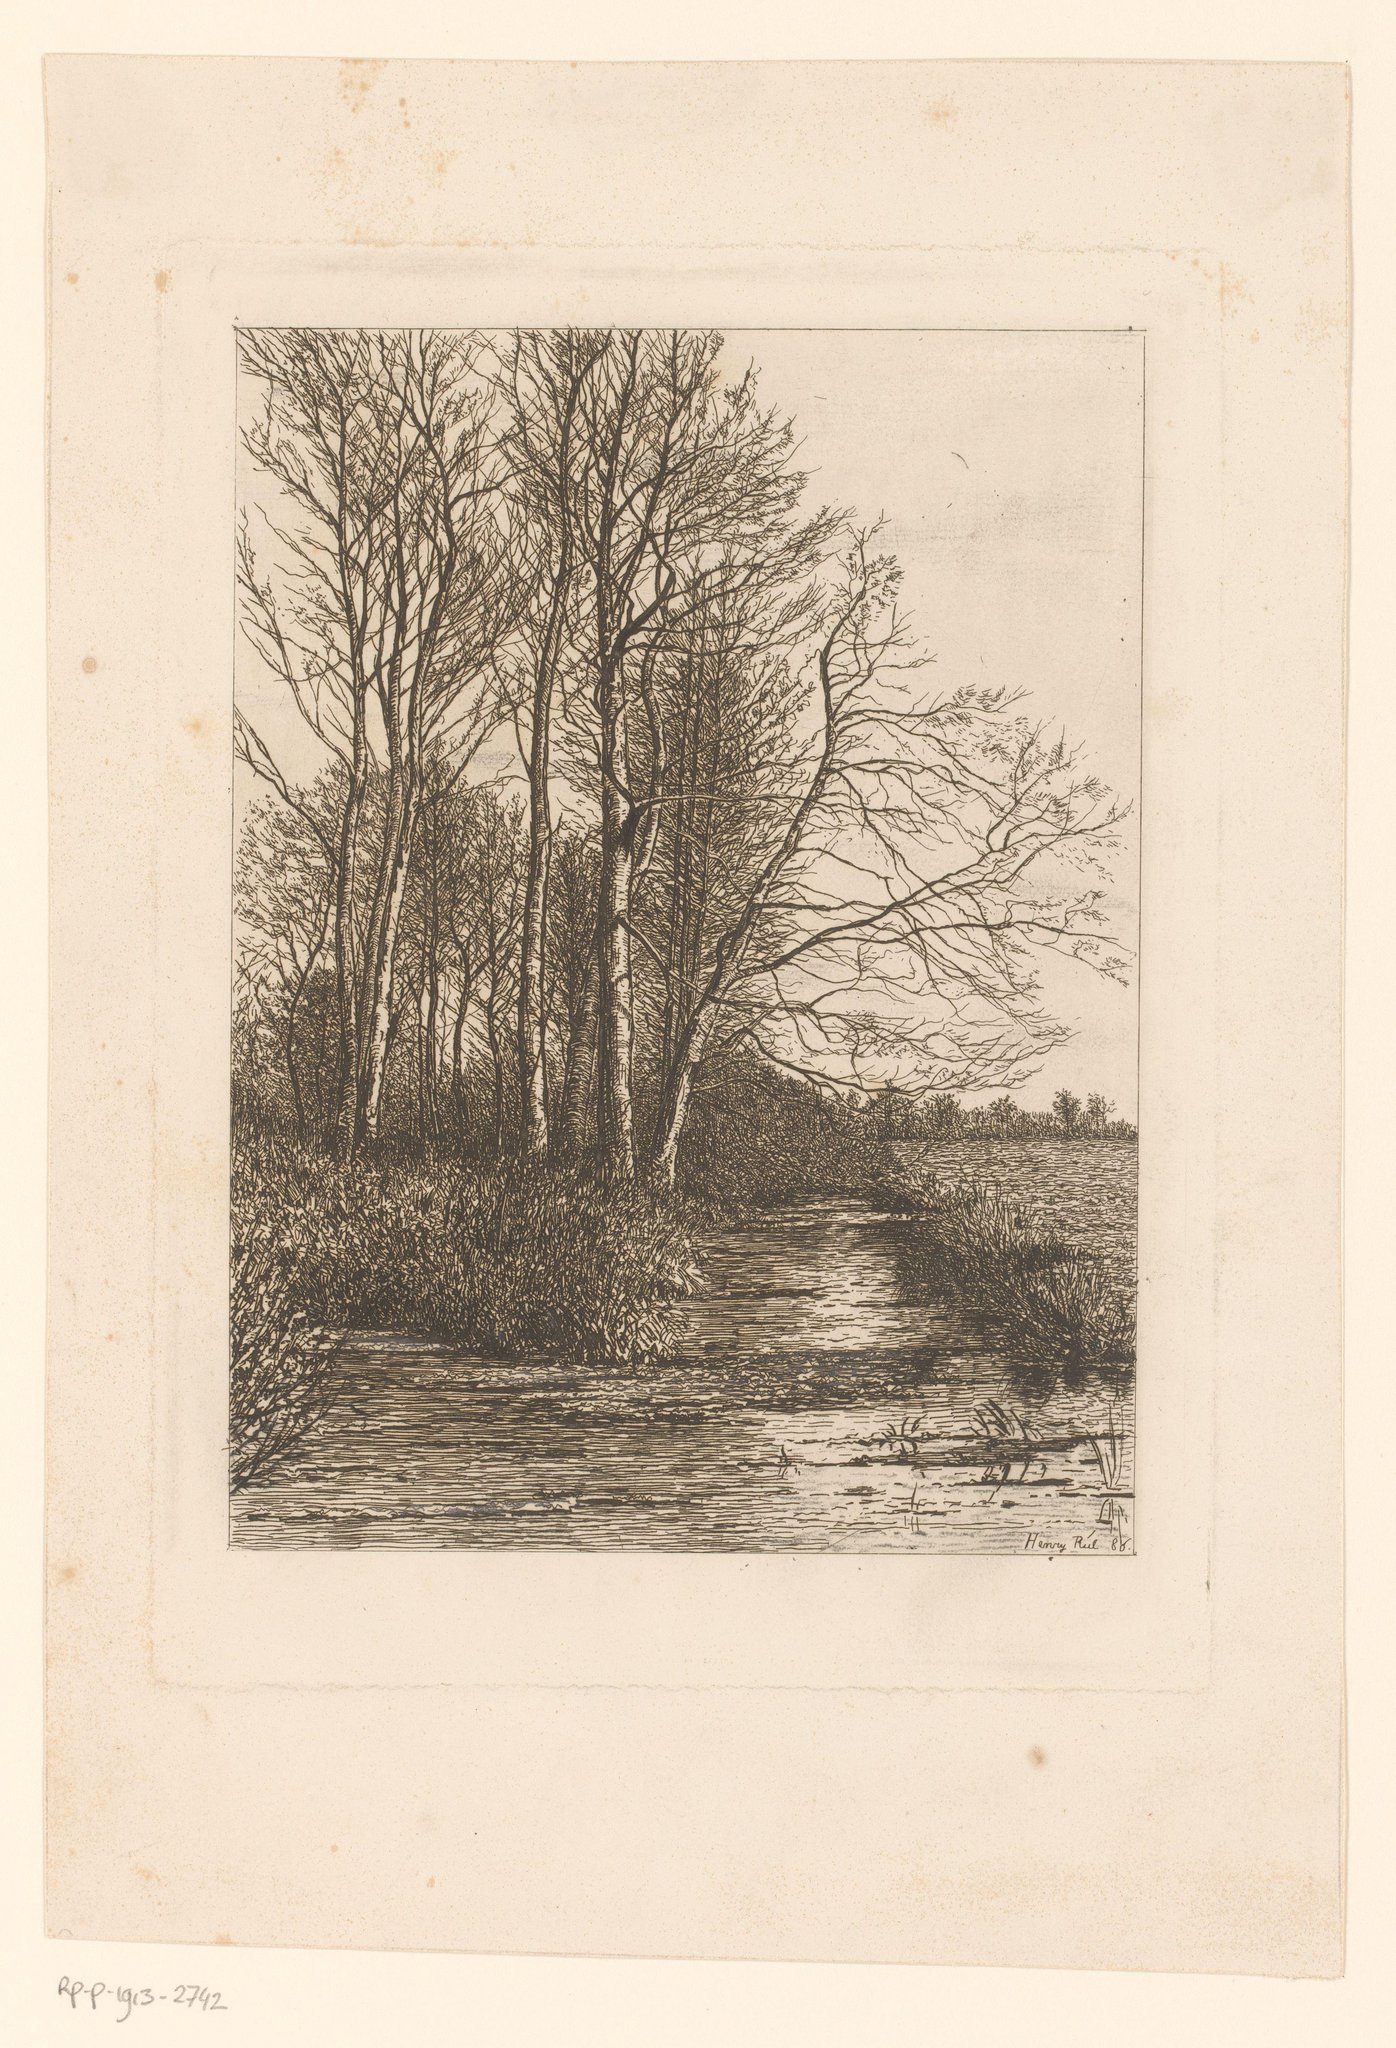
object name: print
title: Sloot aan de rand van een buitenplaats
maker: henri rul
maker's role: print maker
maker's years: 1862-1942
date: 1886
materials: paper, pencil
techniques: etching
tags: brook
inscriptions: collector's mark: Lugt 2228